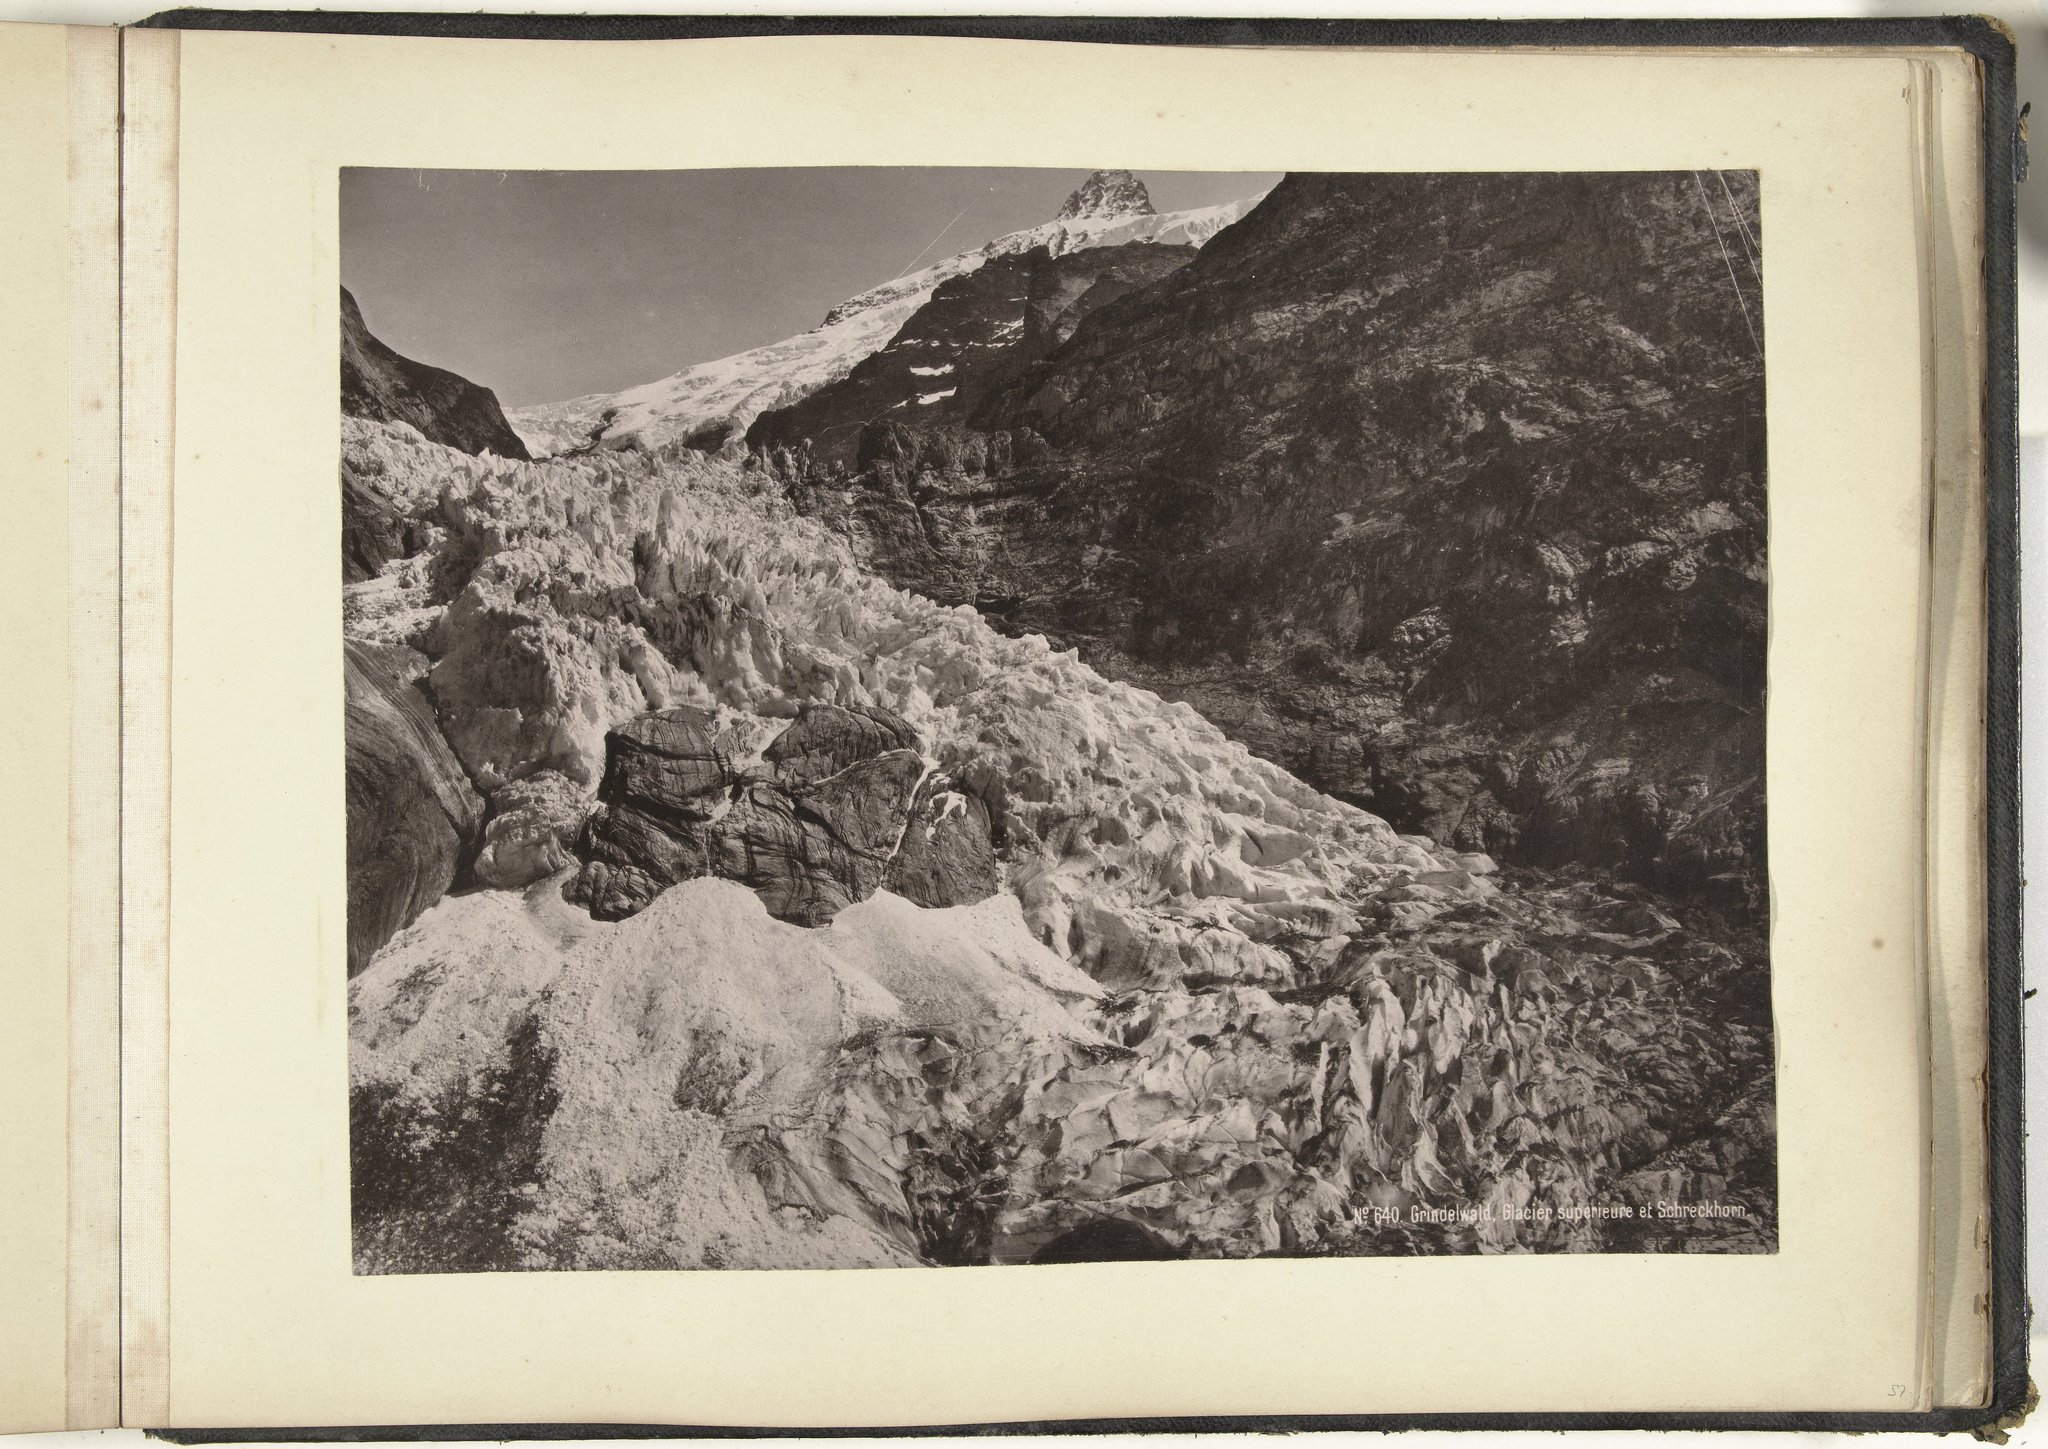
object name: album leaf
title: Grindelwald, Glacier superieure et Schreckhorn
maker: Anonymous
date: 1895-1910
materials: paper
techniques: photograph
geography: grindelwald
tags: glacier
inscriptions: number: ‘No 640.’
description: Deze prent maakt deel uit van een album.